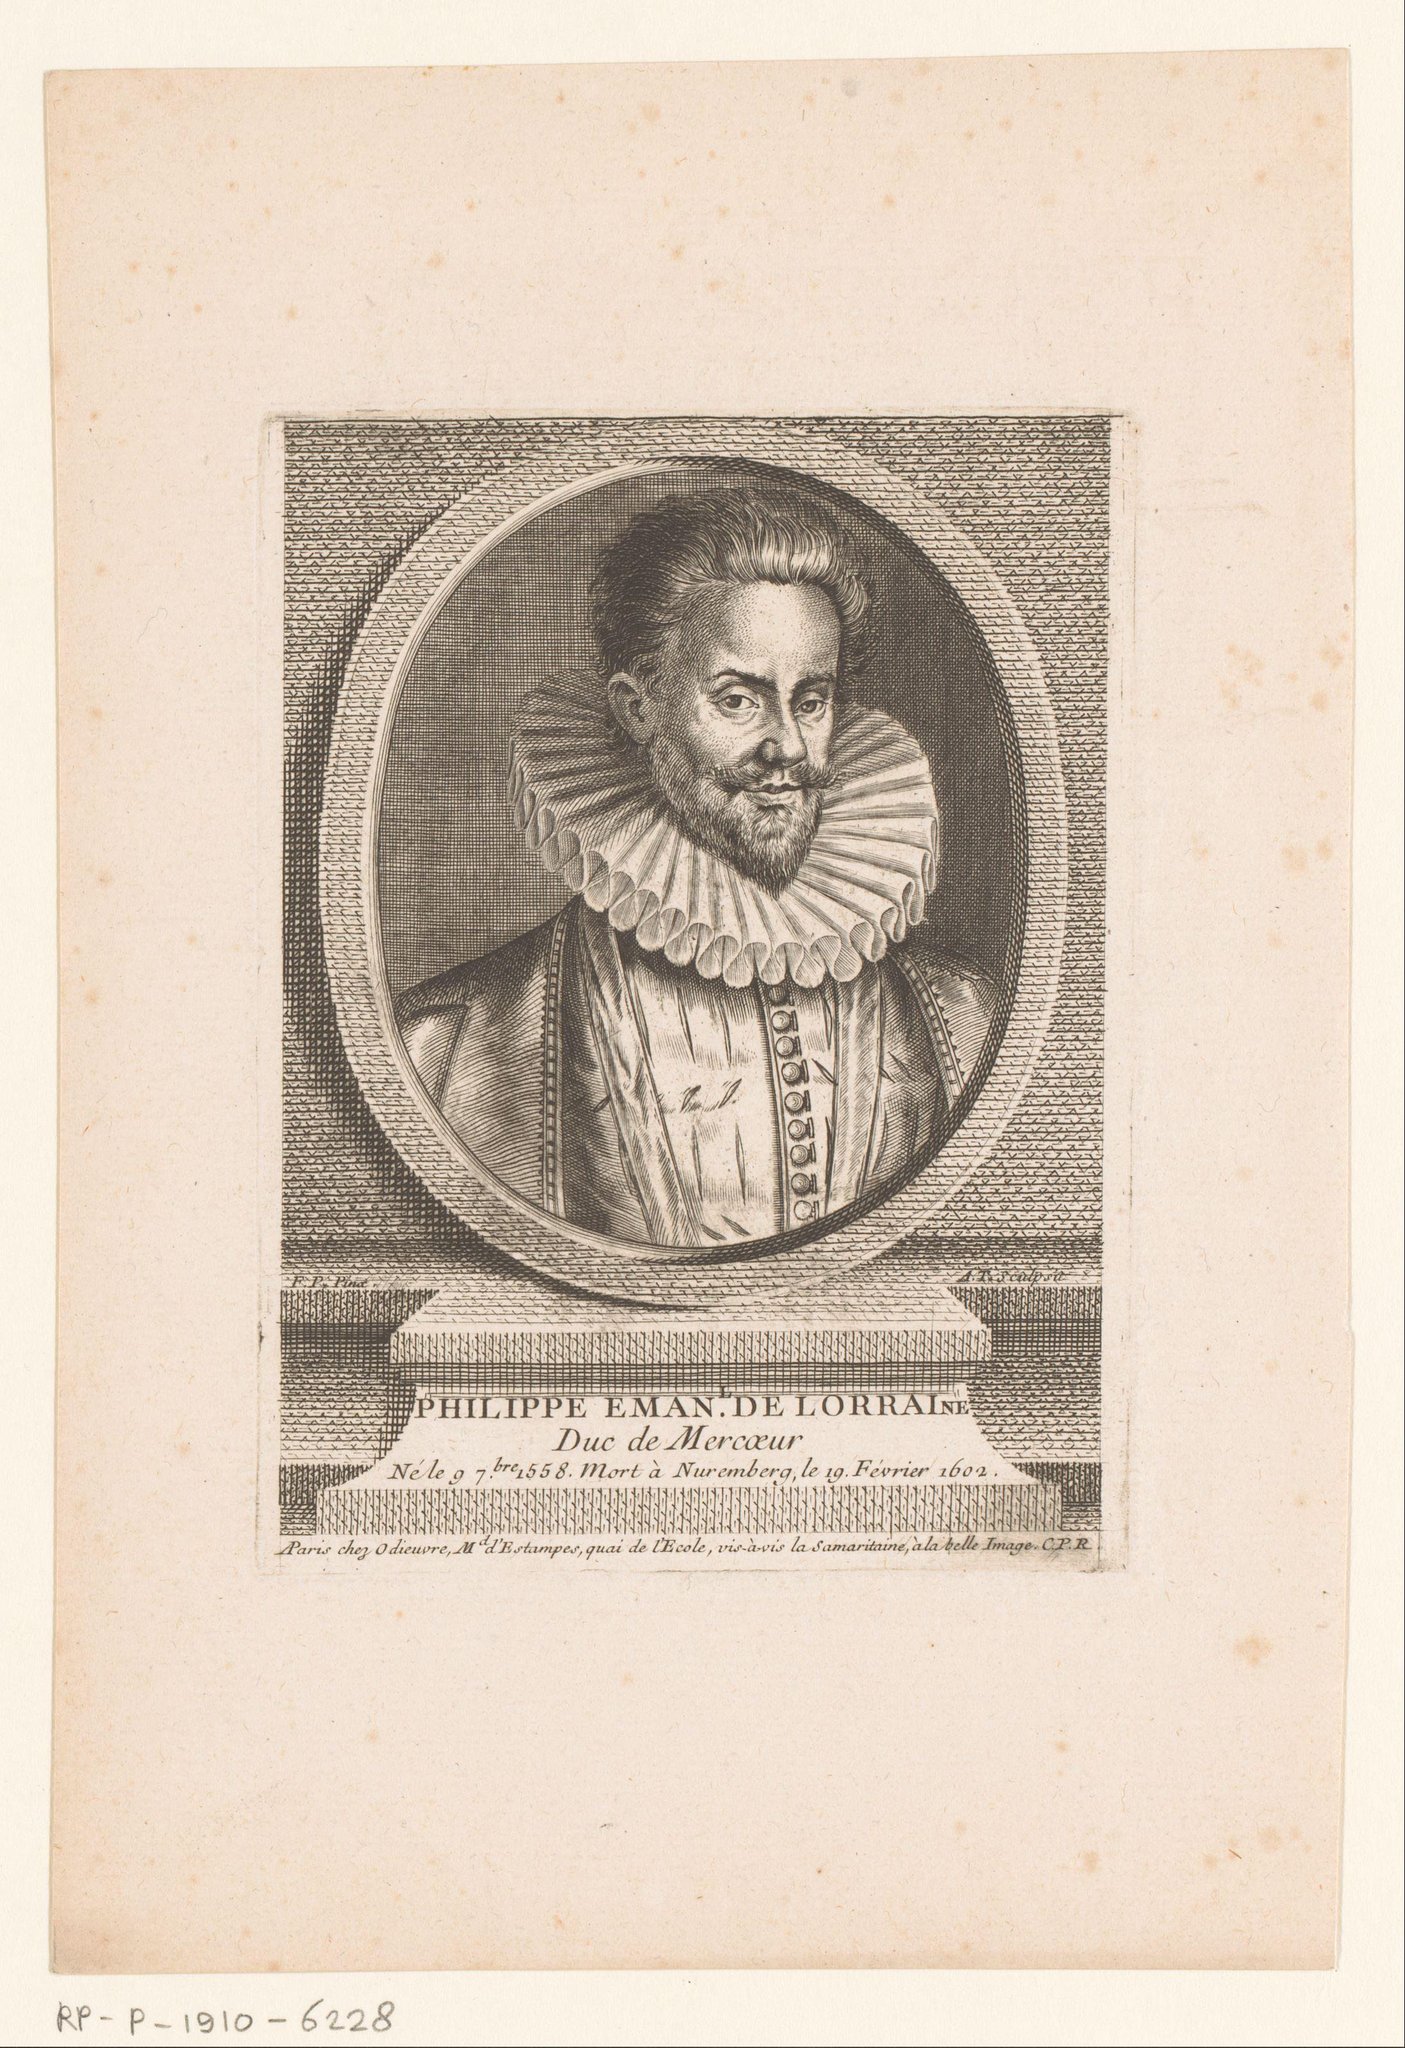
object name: book illustration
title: Portret van Philippe-Emmanuel de Lorraine hertog van Mercoeur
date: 1755-1765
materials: paper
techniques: engraving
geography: paris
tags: historical persons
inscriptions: collector's mark: Lugt 2228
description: Mogelijk prent uit: Dreux du Radier, Jean-François. L'Europe illustré, contenant l'histoire abregée des souverains, des princes, des prélats, des ministres, (...) en Europe: dans le XVe. siècle compris, jusqu'à présent. Parijs: Michel Odieuvre en André-François Le Breton, 1755-1765.